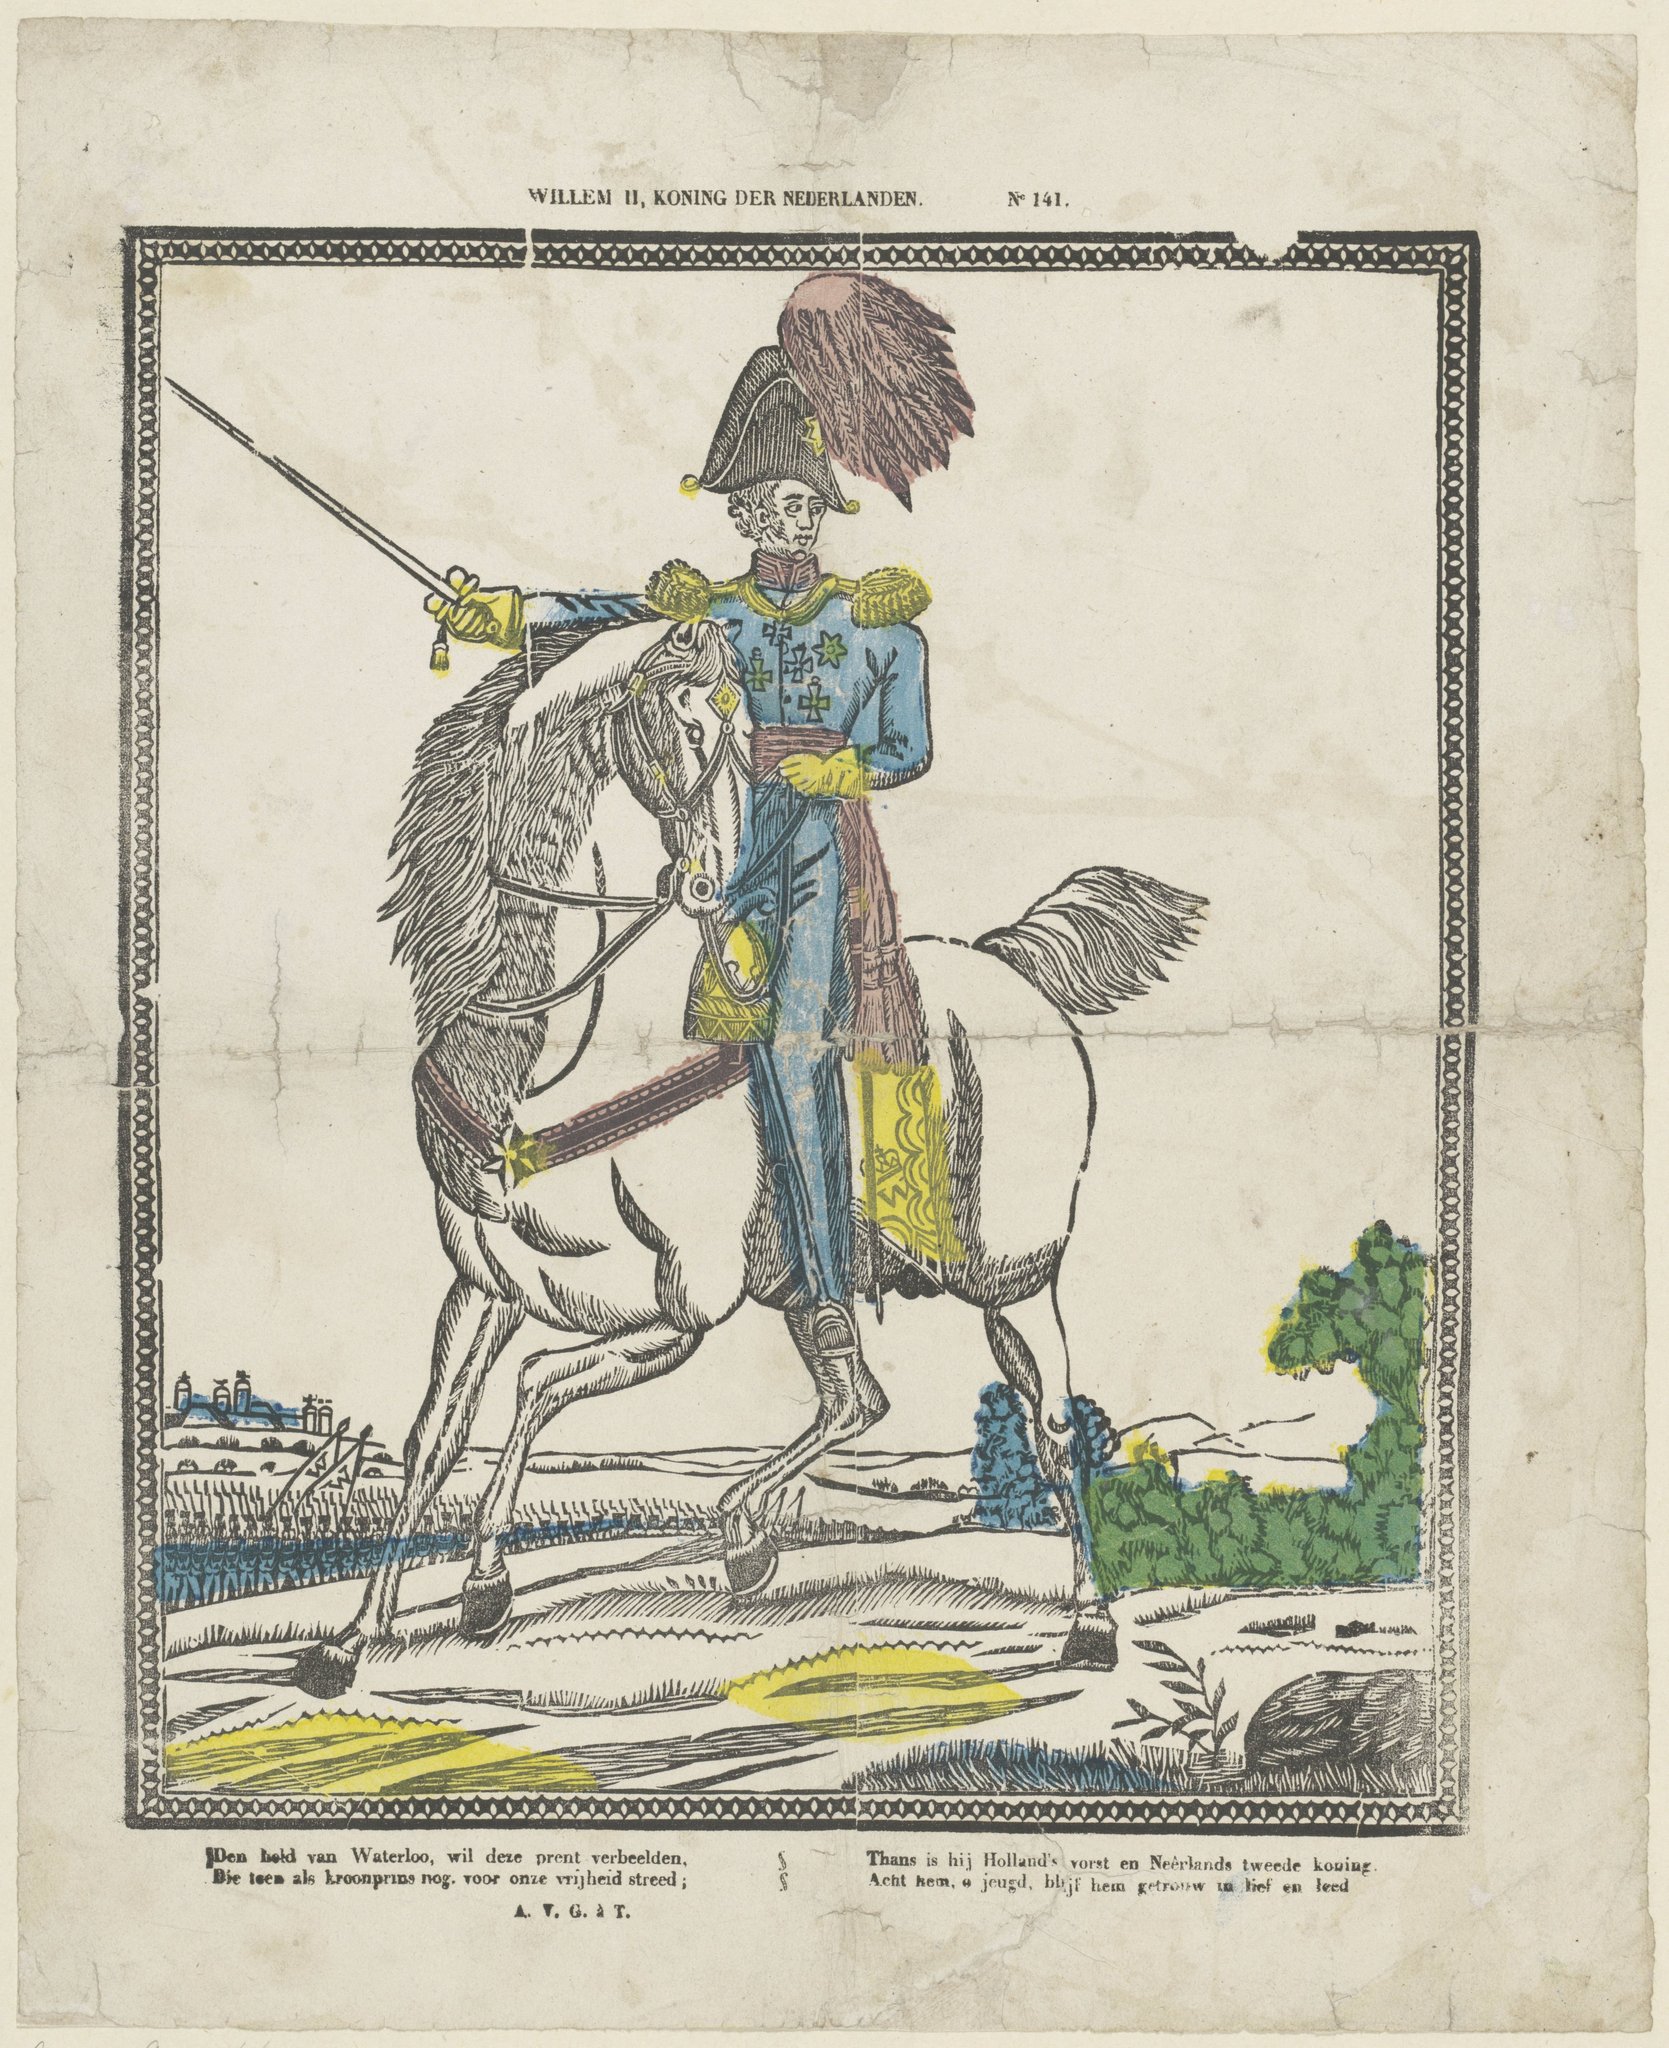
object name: print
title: Ruiterportret van Willem II, koning der Nederlanden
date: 1856-1870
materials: paper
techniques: colour, letterpress printing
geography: turnhout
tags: the hague, william ii of the netherlands, equestrian state-portrait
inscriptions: collector's mark: Lugt 2760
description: Blad met een grote voorstelling van Willem II te paard in een landschap. Geheel omgeven door een sierlijst. In de ondermarge een vierregelig vers in twee kolommen. Genummerd rechtsboven: No. 141.